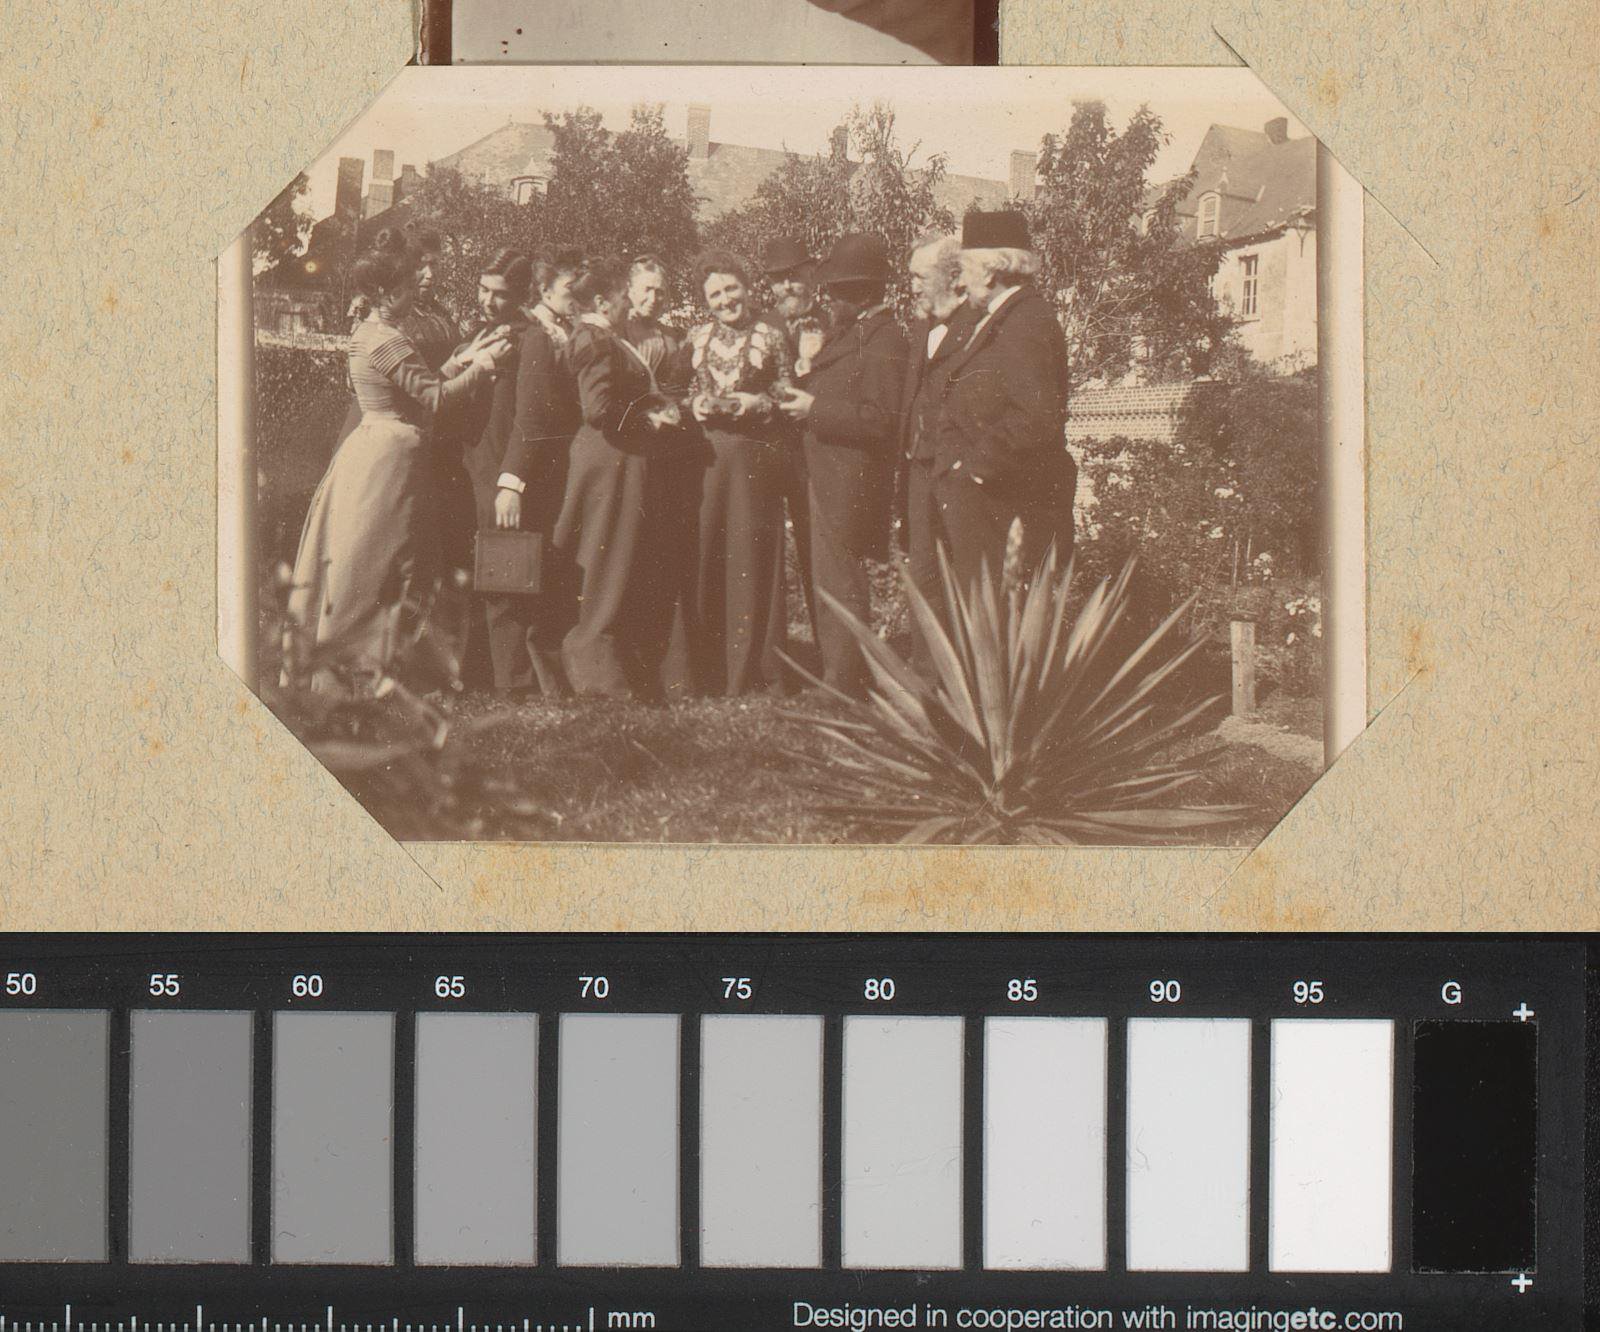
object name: album leaf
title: Groepsportret van gezelschap in een tuin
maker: Anonymous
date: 1897-1900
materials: paper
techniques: gelatin silver print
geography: france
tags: garden, anonymous historical person portrayed, three generations (family group), france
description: Over de foto is een ander negatief afgedrukt van een voorstelling van bomen.